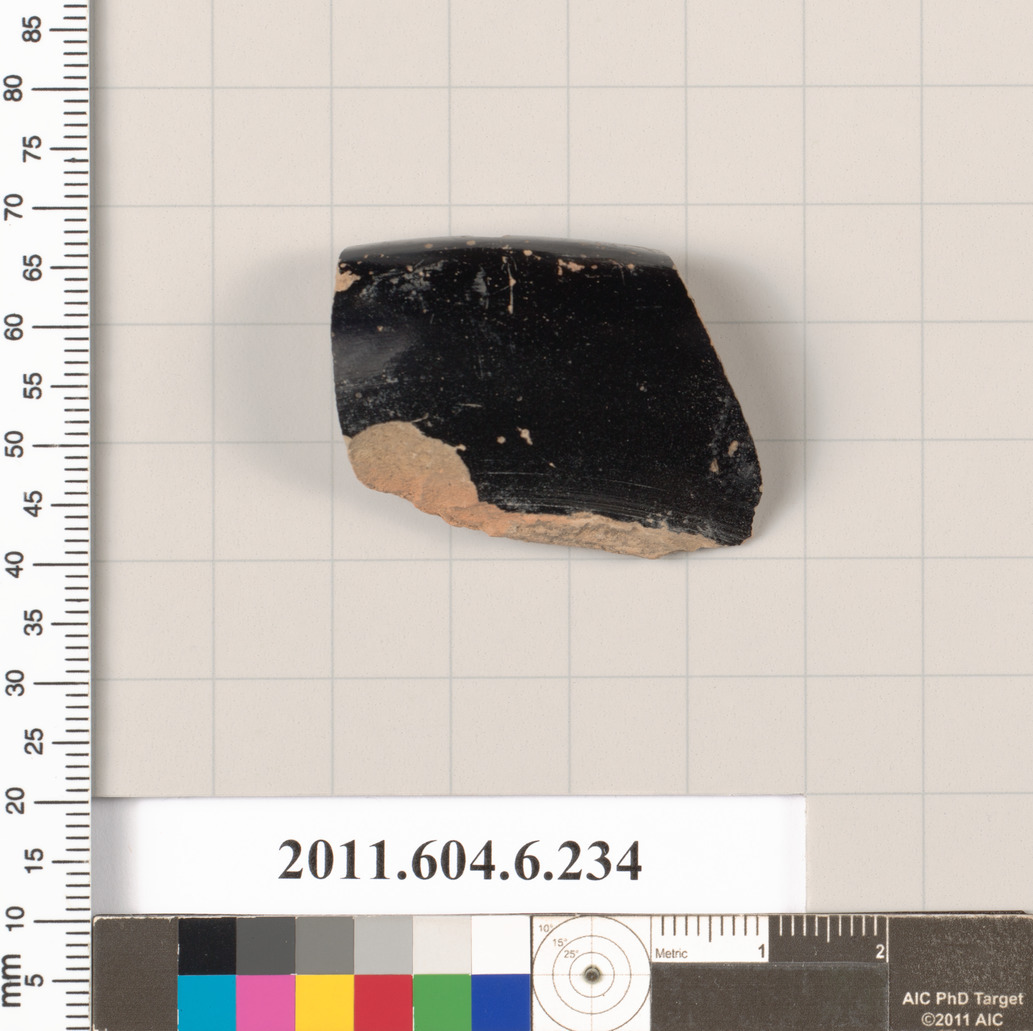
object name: salt cellar fragment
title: Terracotta fragment of a salt cellar?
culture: greek, attic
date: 500-451 BCE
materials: terracotta